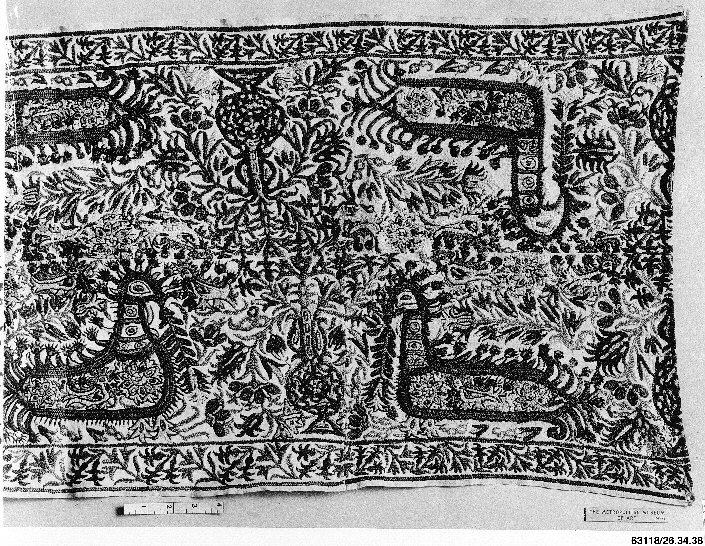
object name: textile fragment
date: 1701-1800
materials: linen, silk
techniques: embroidery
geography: greece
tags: birds